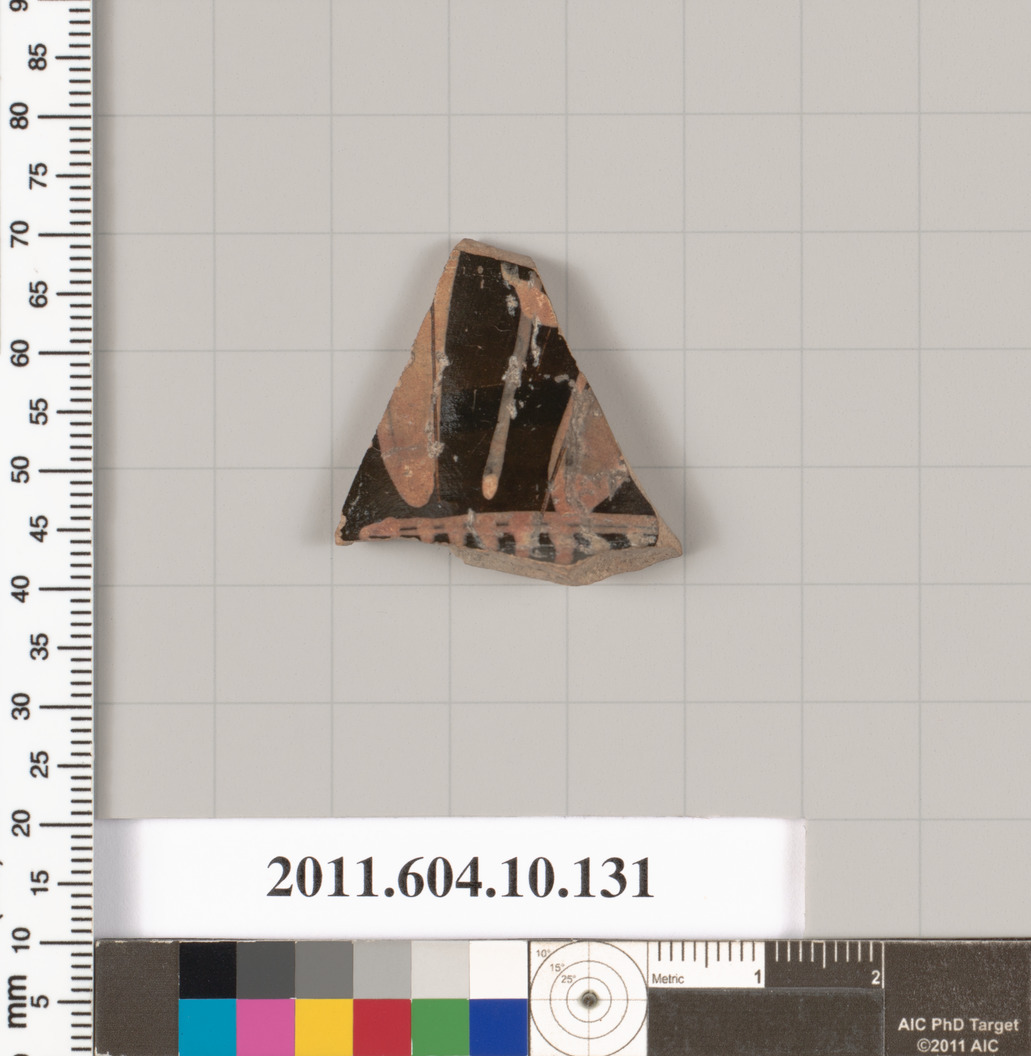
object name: undetermined closed shape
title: Terracotta fragment of a closed shape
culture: etruscan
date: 434-368 BCE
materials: terracotta